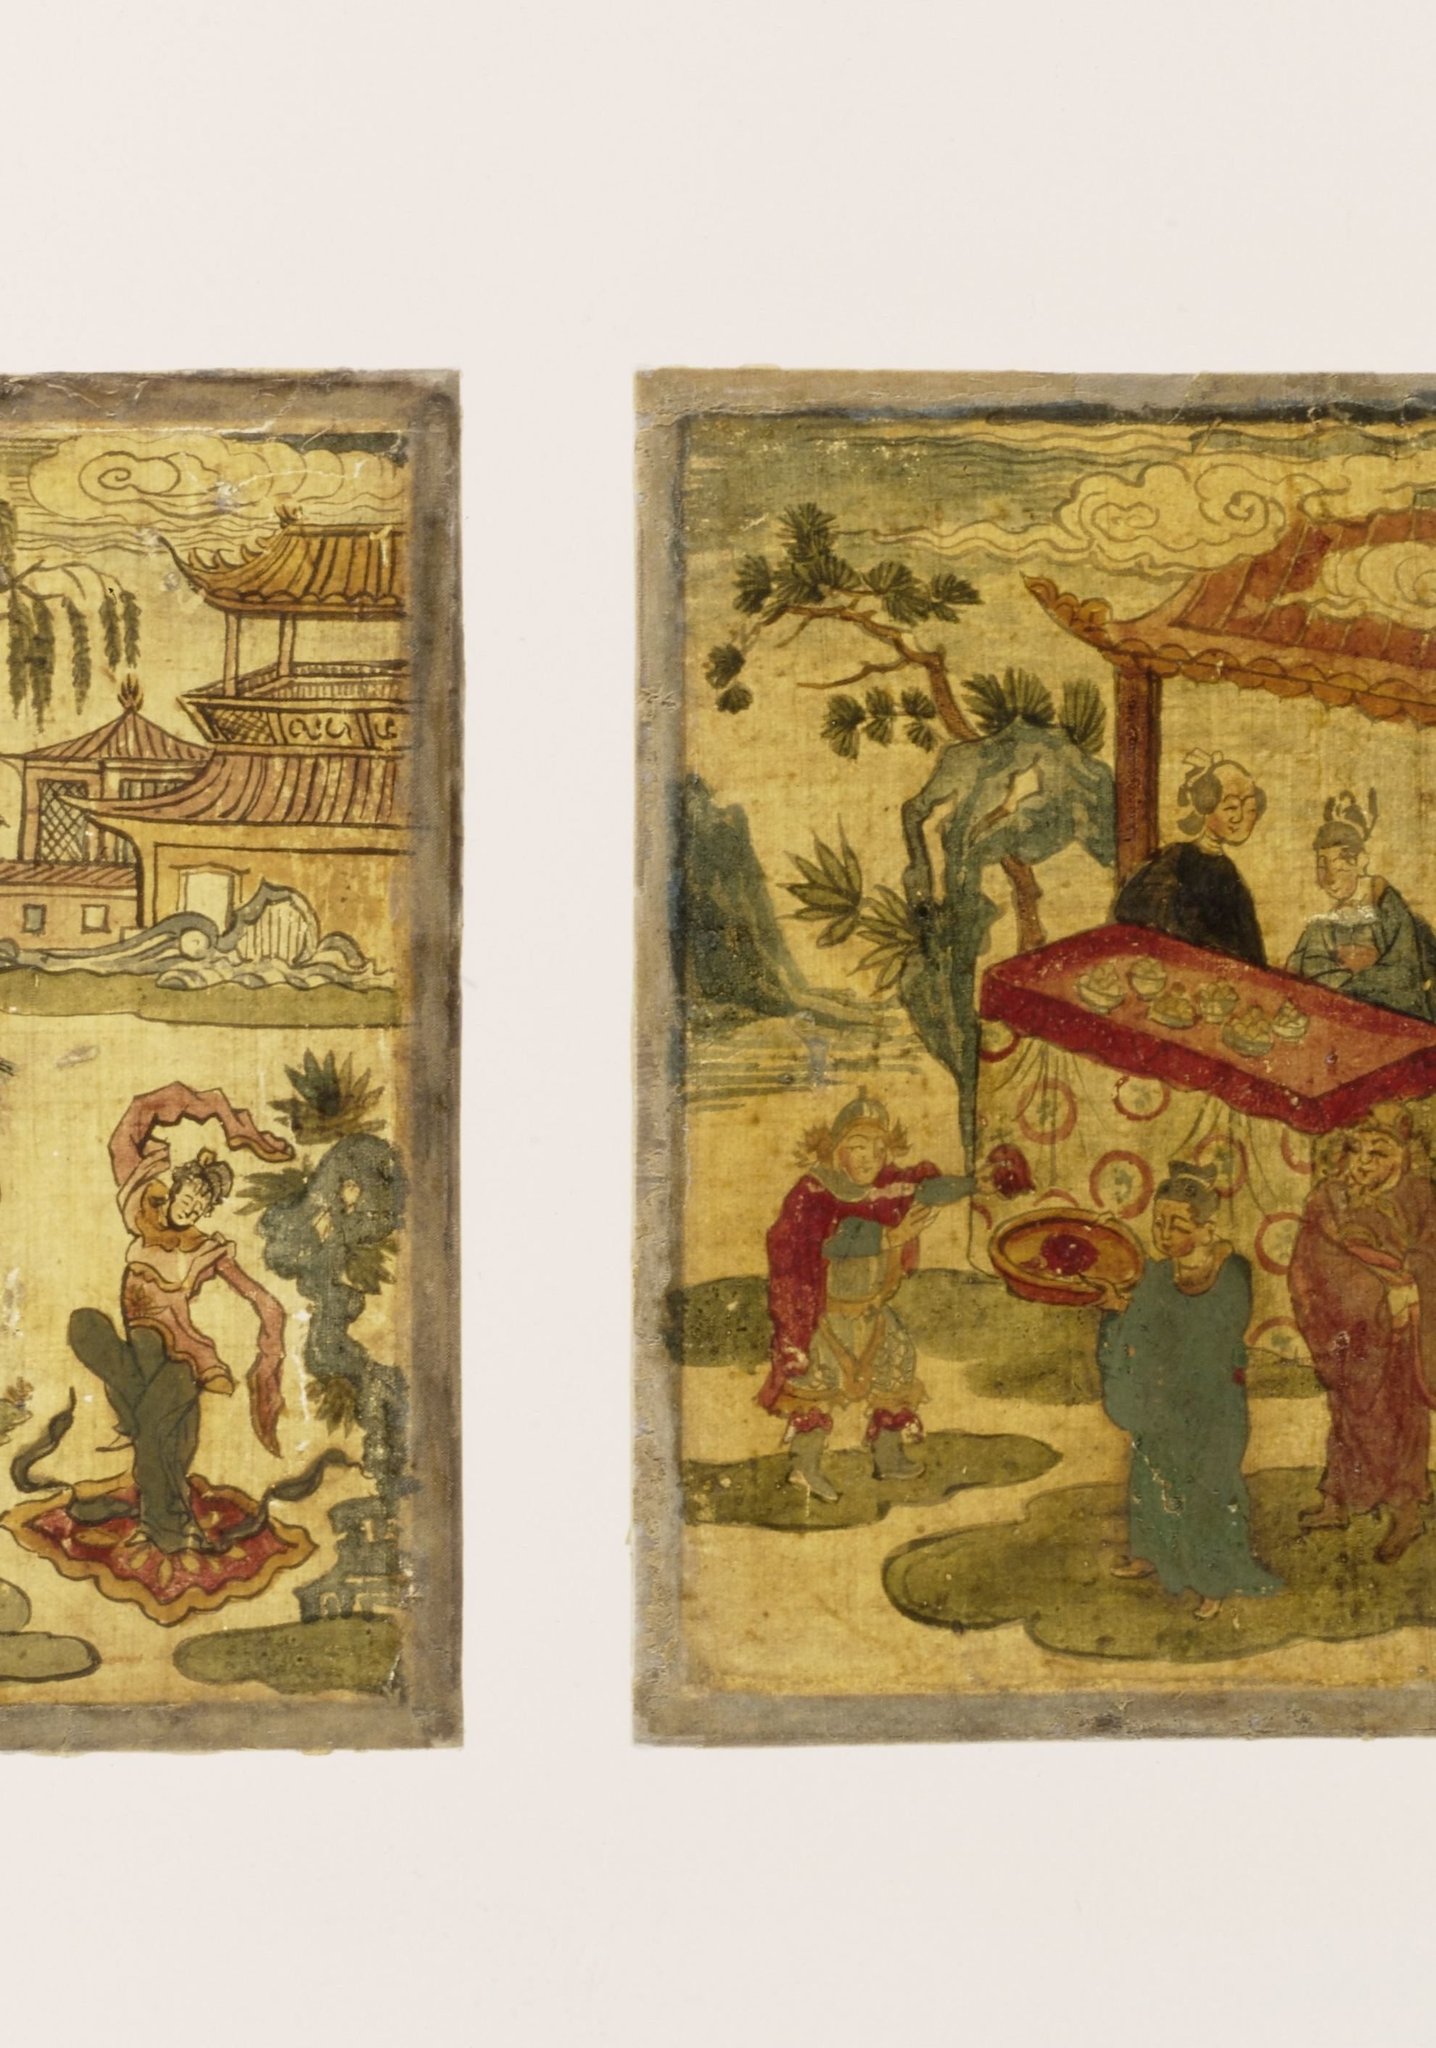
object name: storm window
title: Voorzetraam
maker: Anonymous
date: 1702-1710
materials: gouache, resin, silk, wood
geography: amsterdam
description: Sassinet of beschilderde voorzetraam; vervaardigd uit een smal houten raamwerk, bespannen met crème-kleurige zijde die beschilderd is met Chinoiserieën. De voorstelling is niet geidentificeerd.